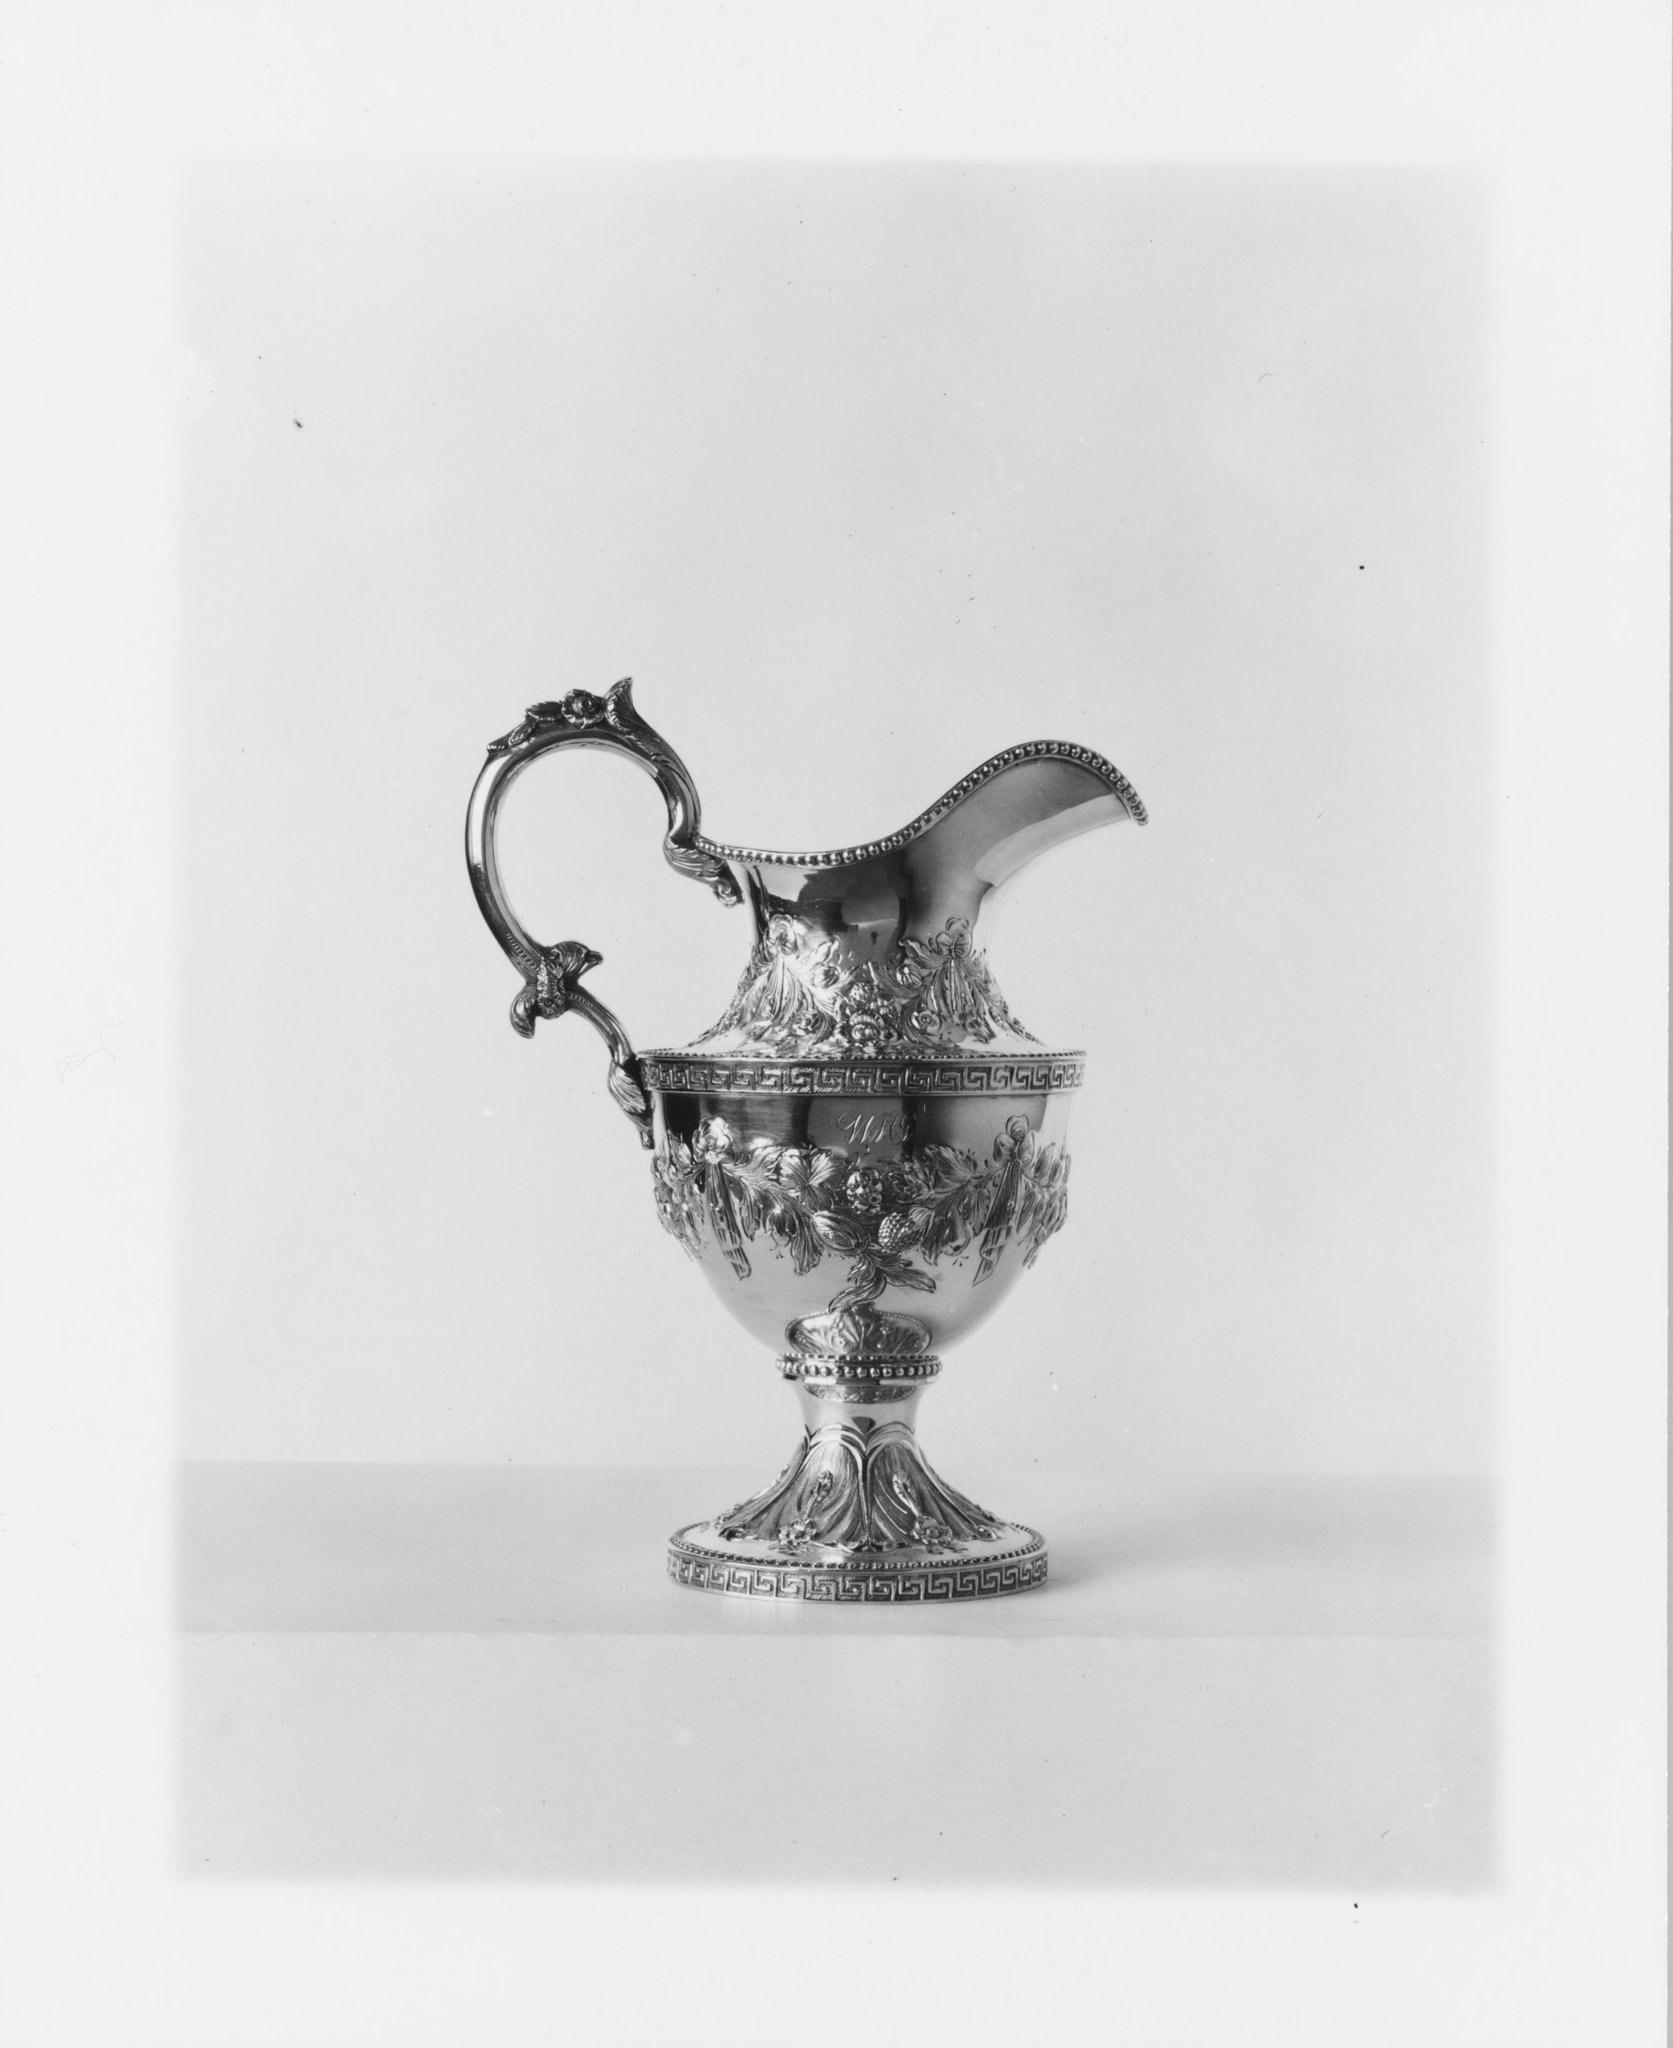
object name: cream pot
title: Creamer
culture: american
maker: robert and william wilson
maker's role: maker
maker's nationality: american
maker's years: 1825-1846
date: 1835-1845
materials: silver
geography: united states